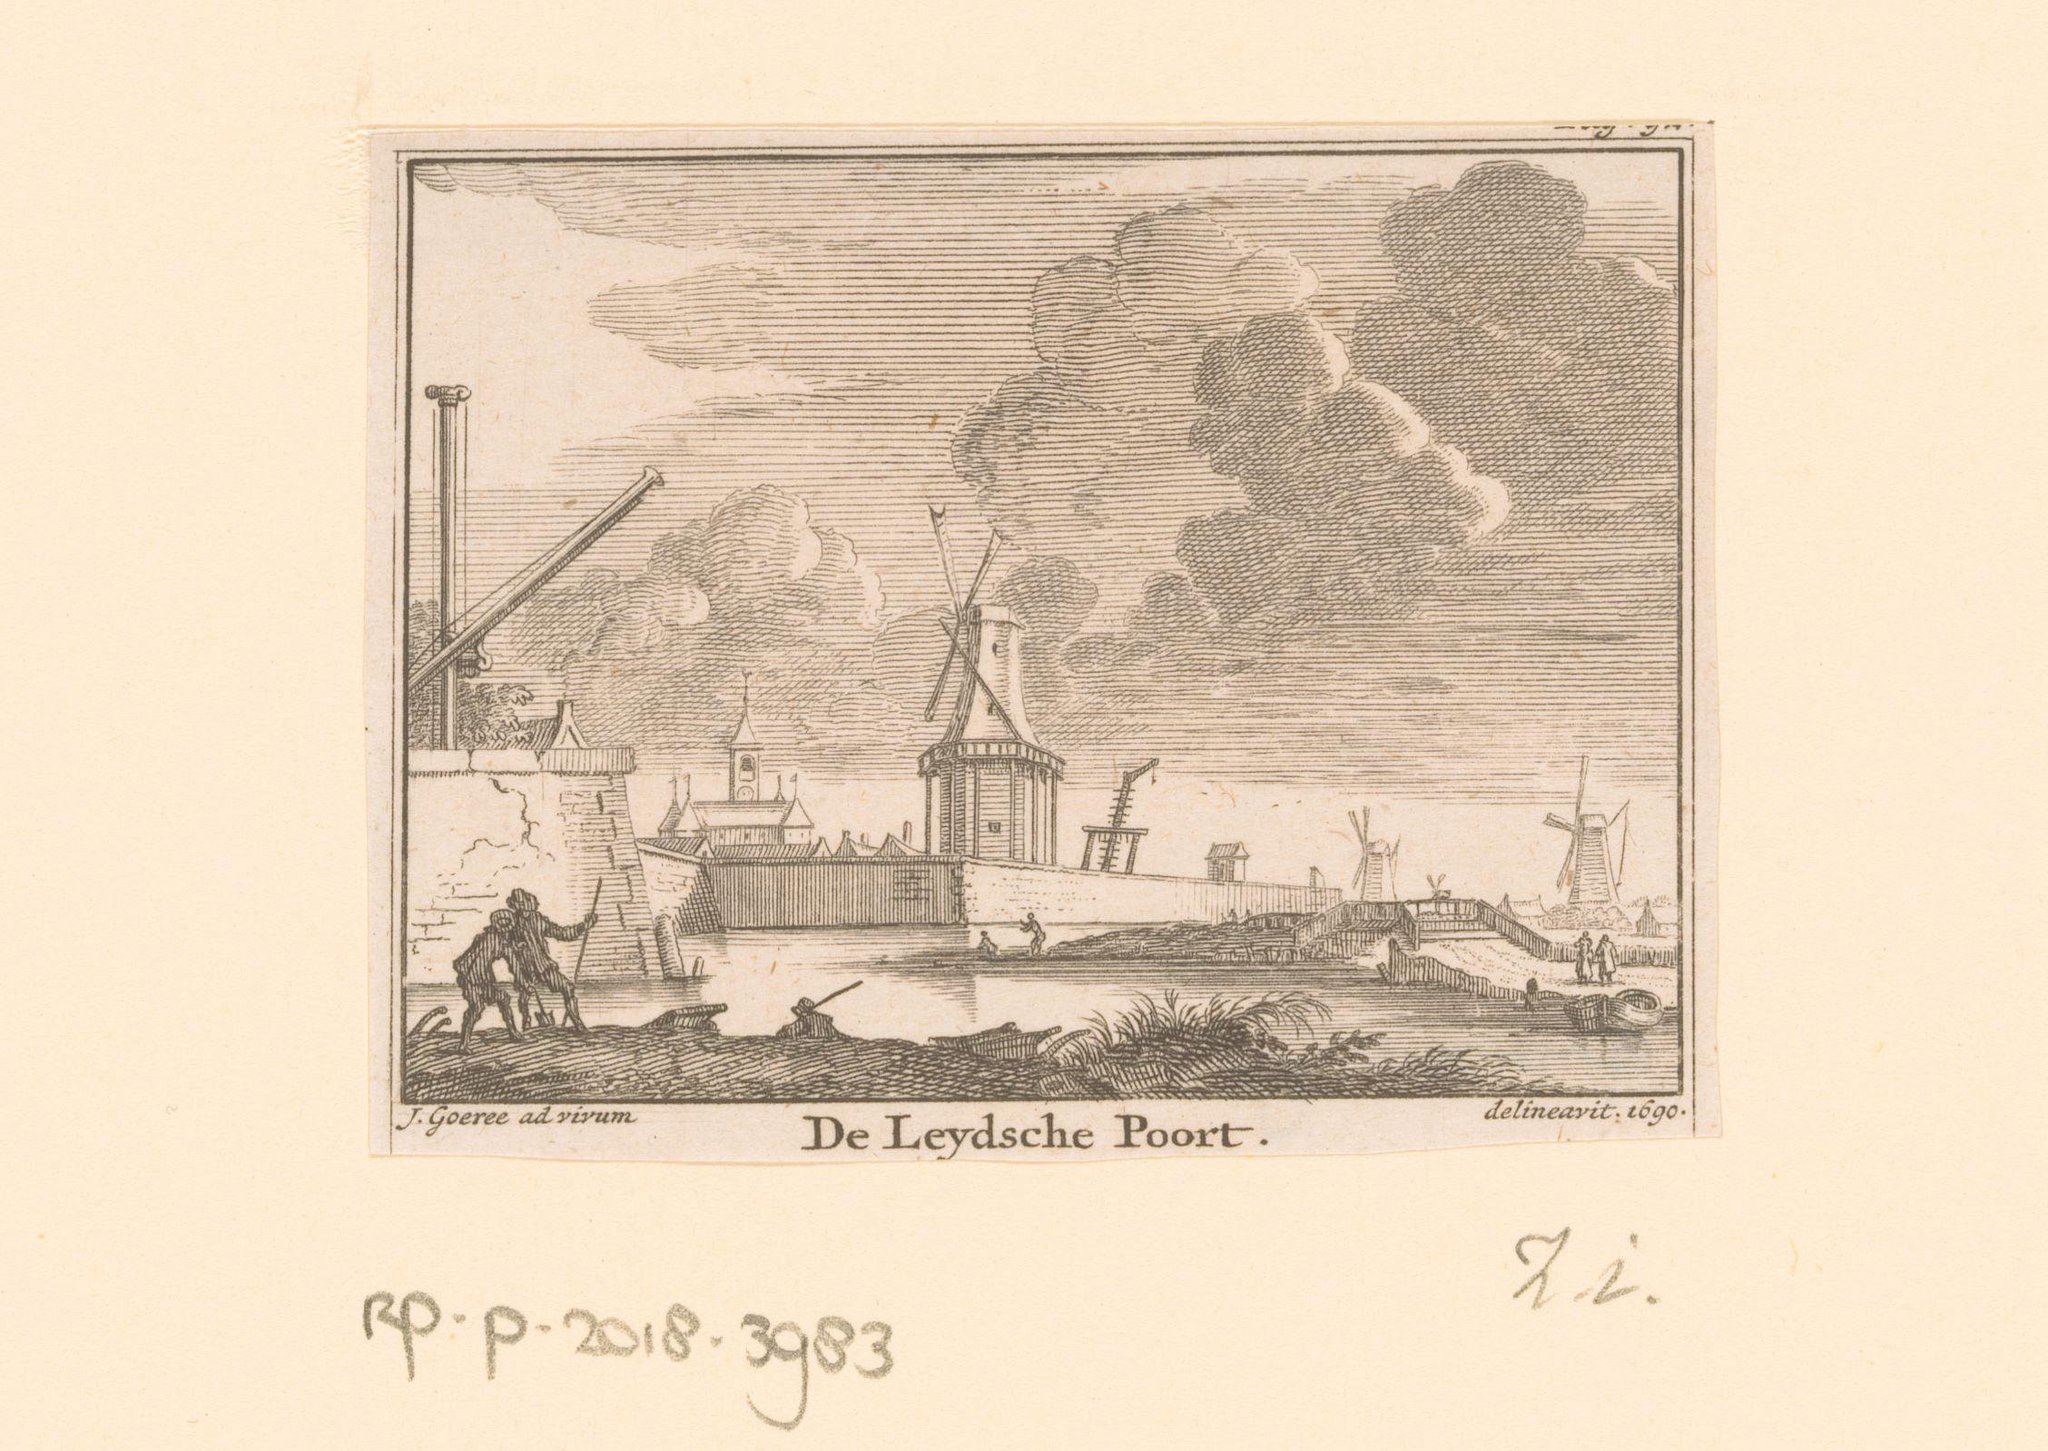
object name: print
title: De Leydsche poort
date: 1723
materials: paper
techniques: engraving, etching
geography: amsterdam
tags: windmill in landscape, bridge in city across river, canal, etc.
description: Prent uit: Willink, Daniël. Amsterdamsche buitensingel, nevens de omleggende dorpen (...). Amsterdam: Andries van Damme, 1723, tussen p. 92-93.